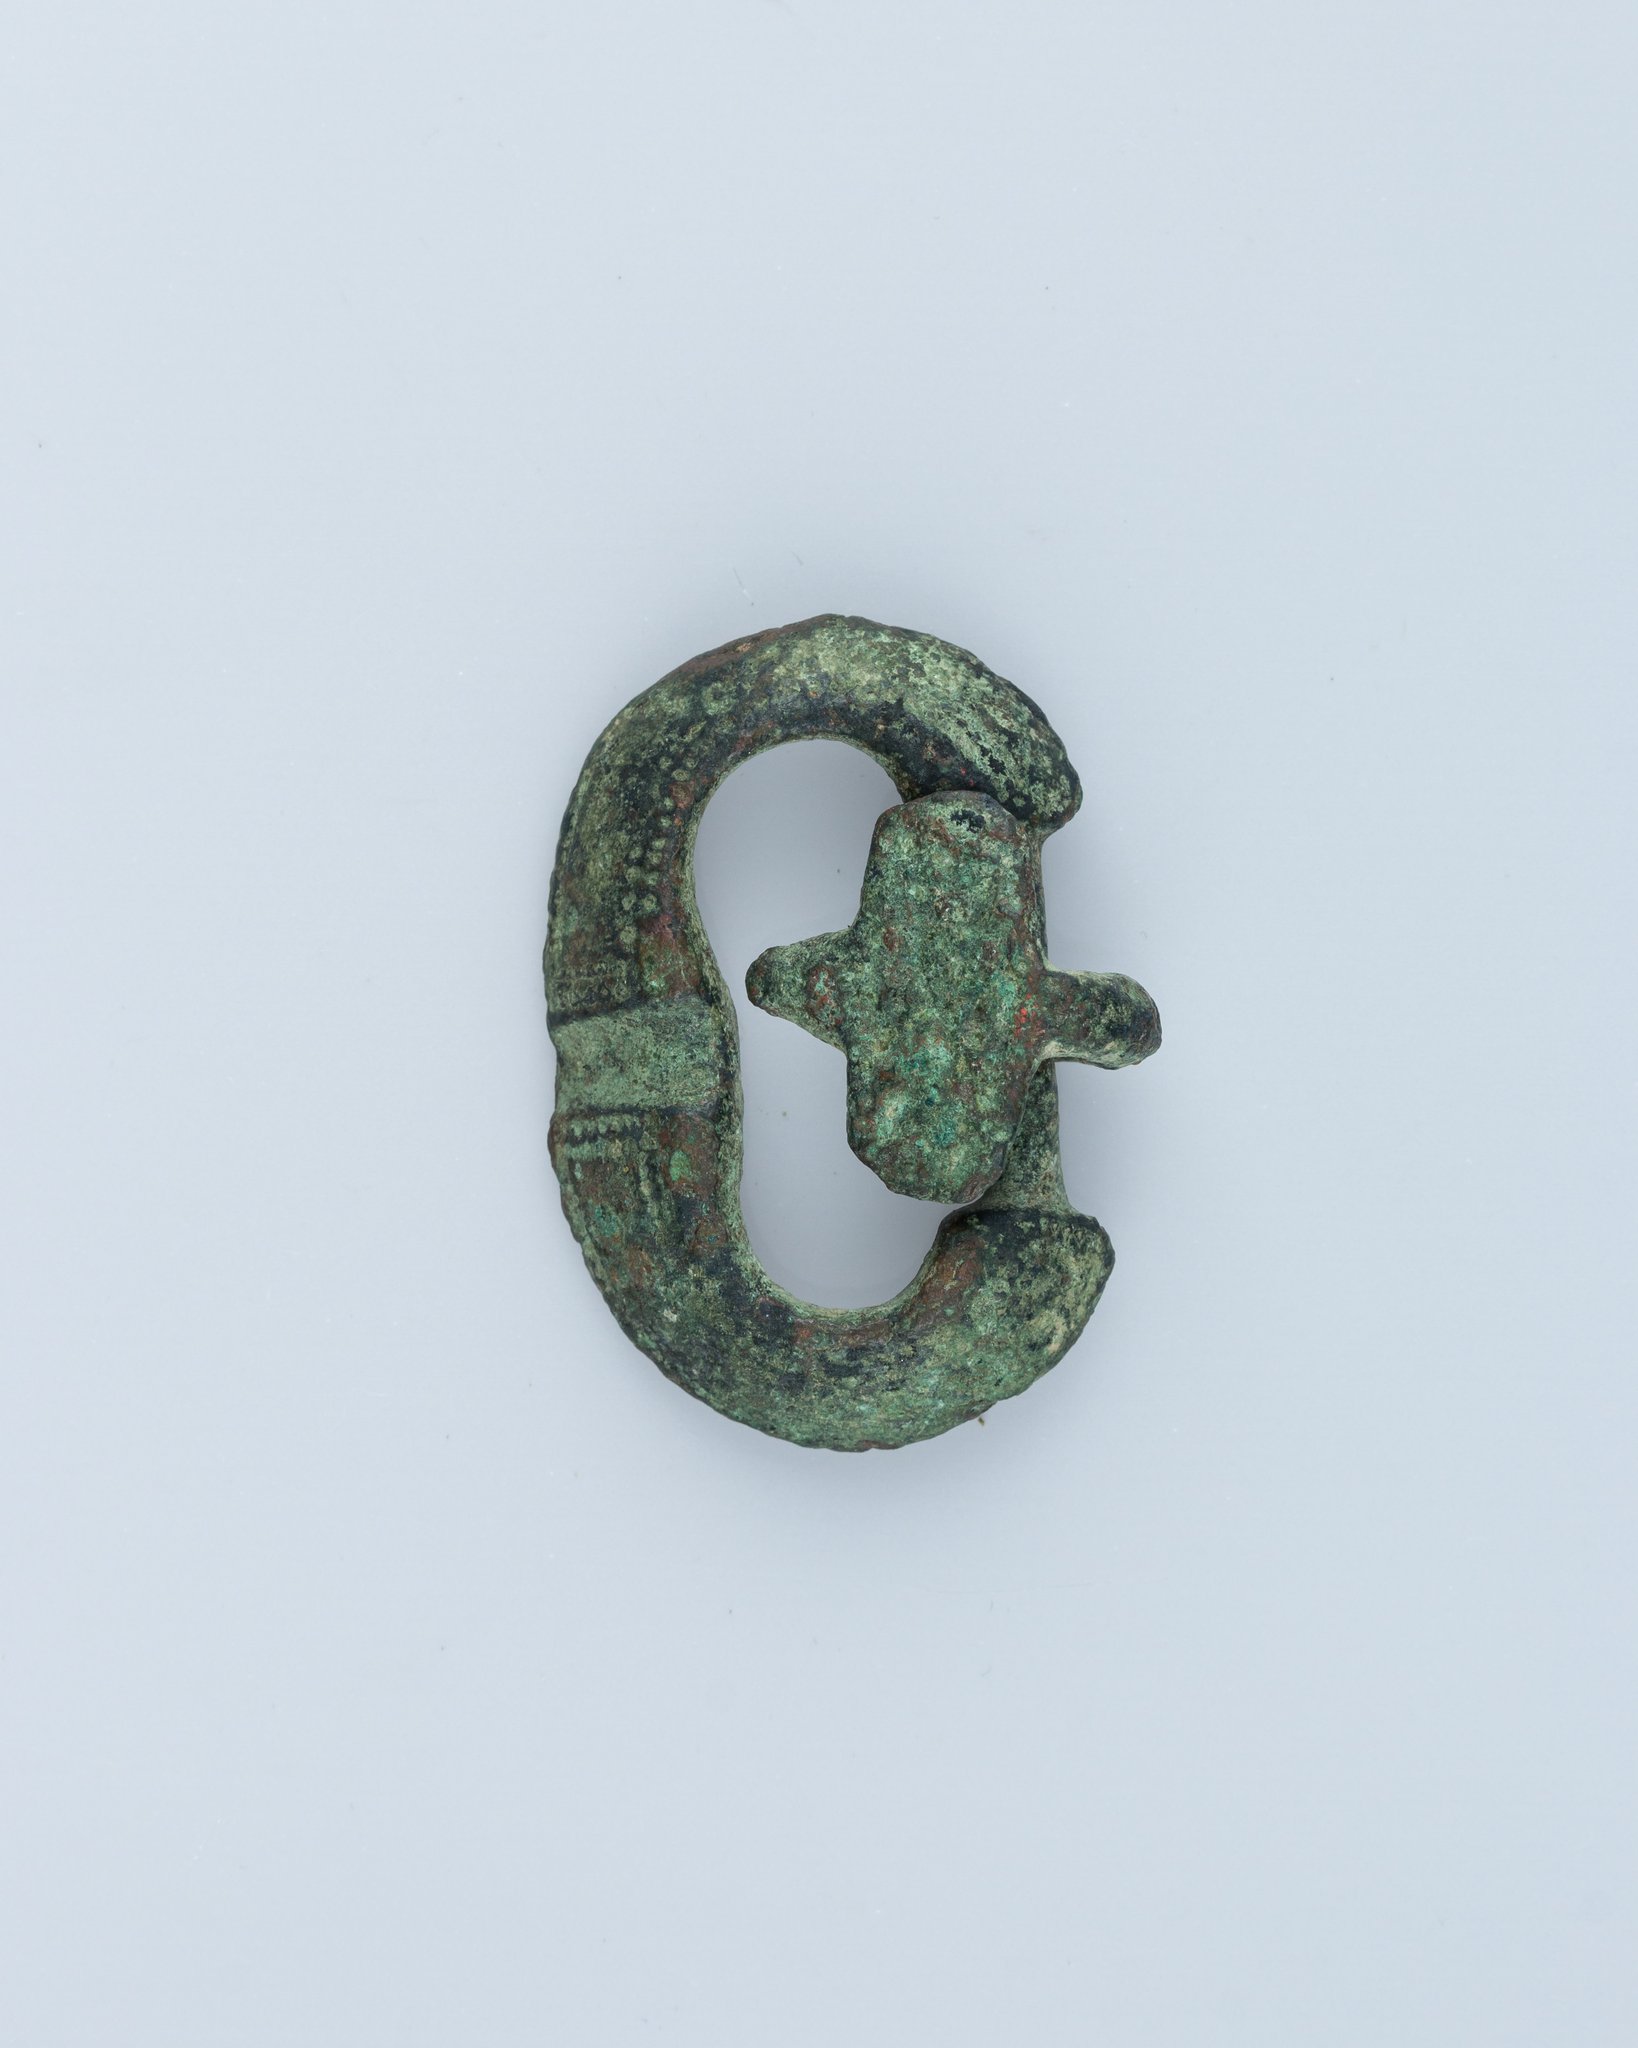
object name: buckle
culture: ibero-roman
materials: bronze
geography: spain or portugal